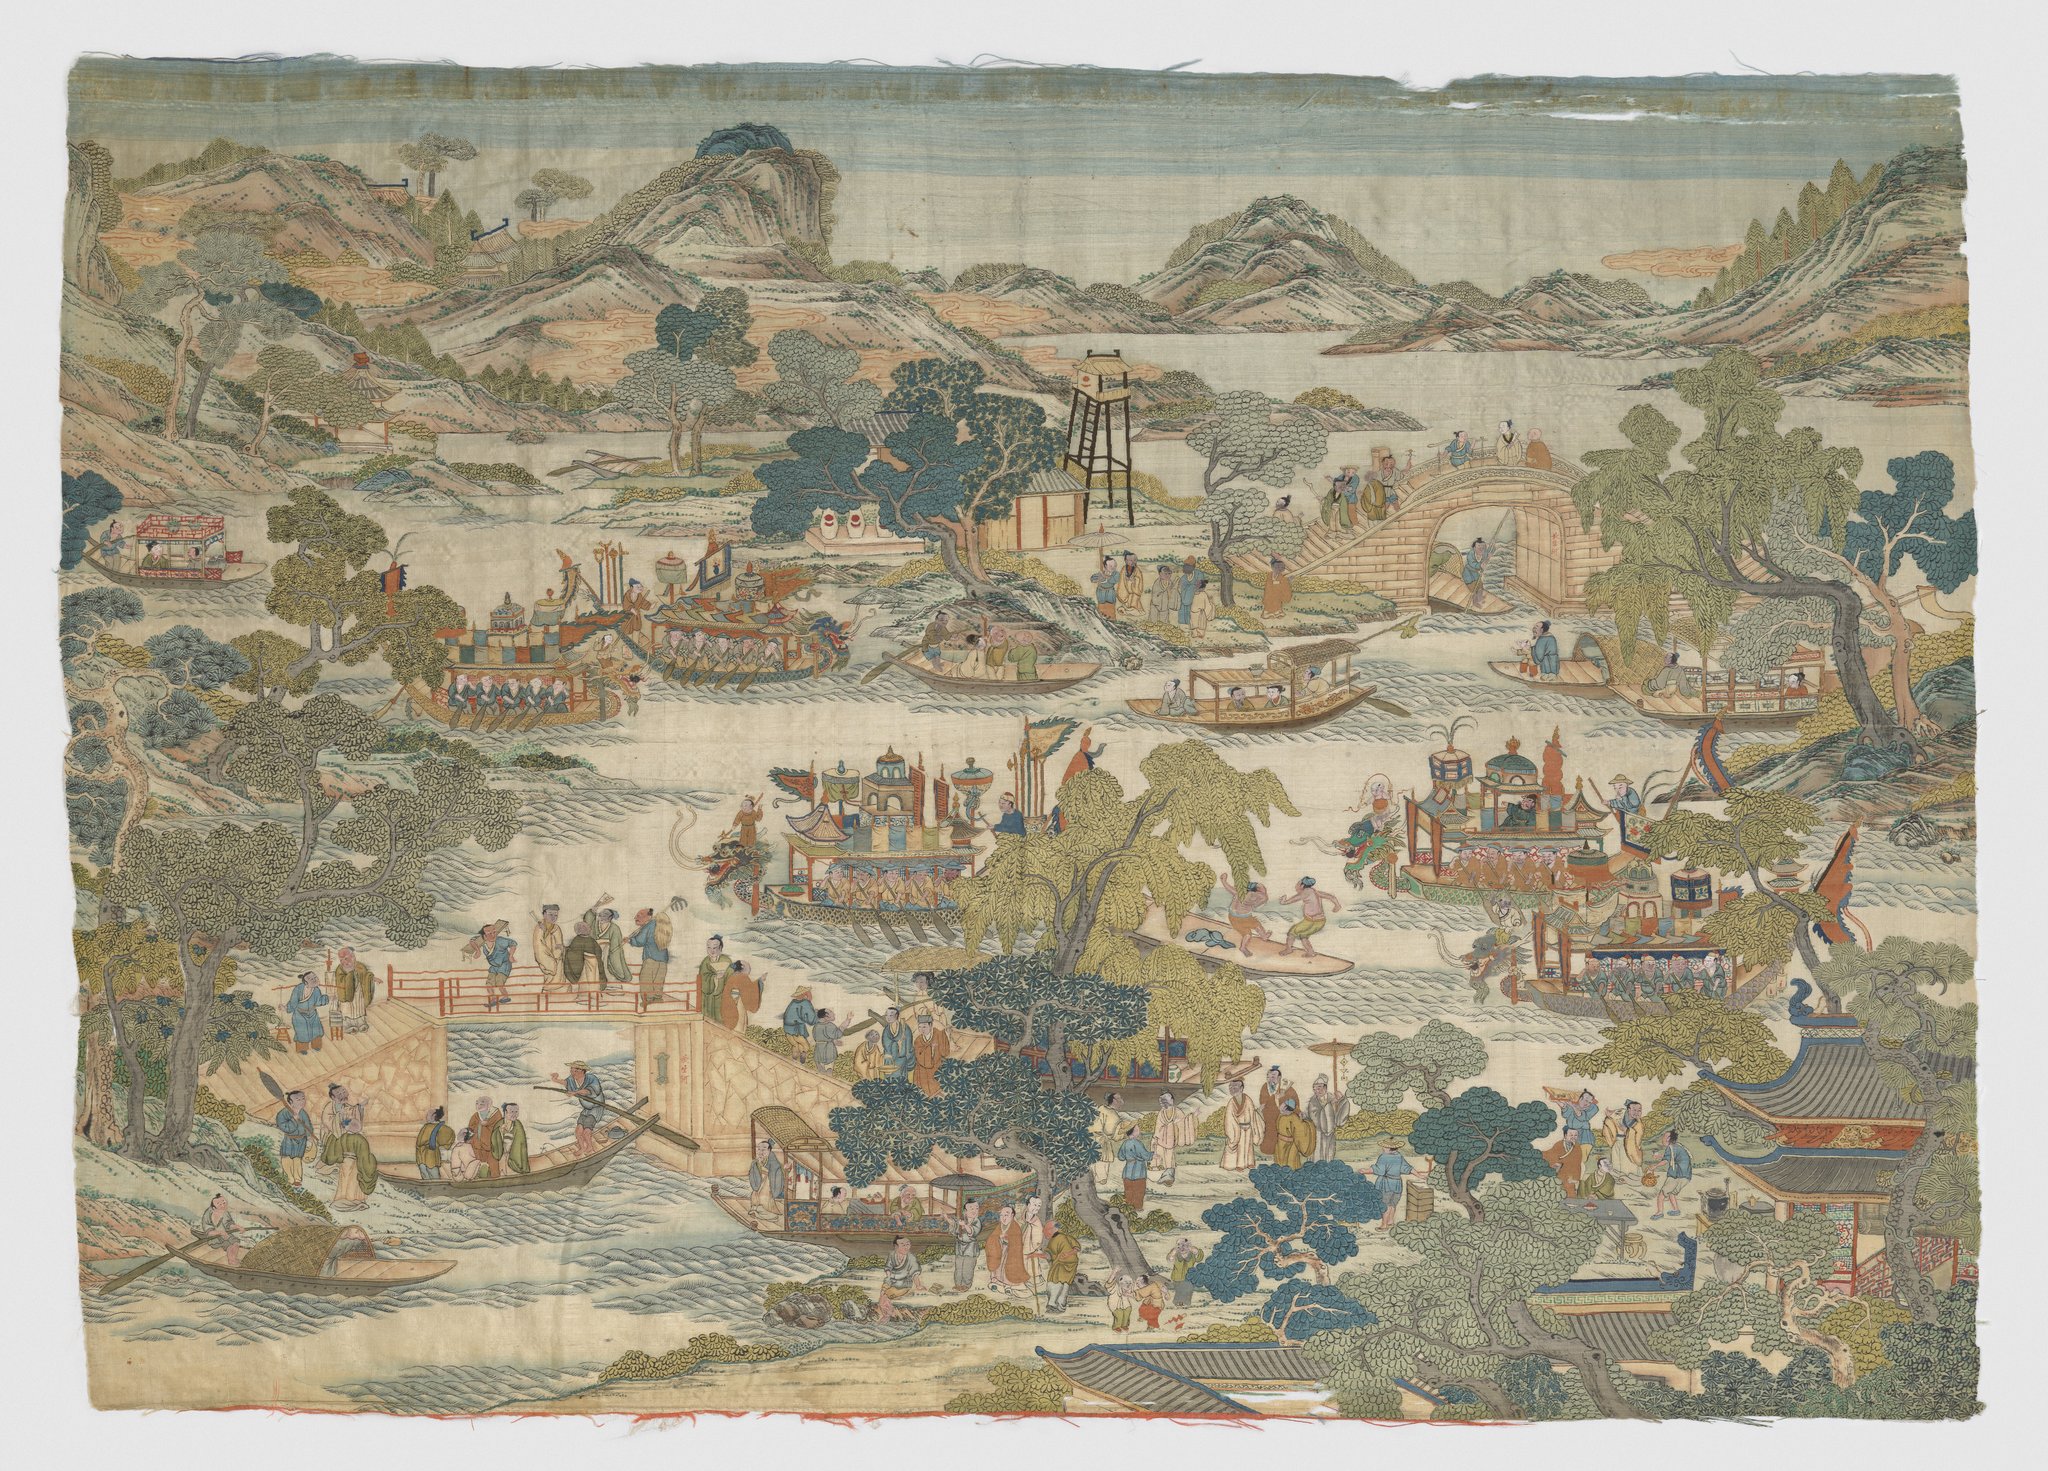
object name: panel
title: Dragon-boat festival performance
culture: chinese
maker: unidentified artist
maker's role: artist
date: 1701-1900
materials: metal thread, silk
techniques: tapestry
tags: performance,bridges,landscapes,boats